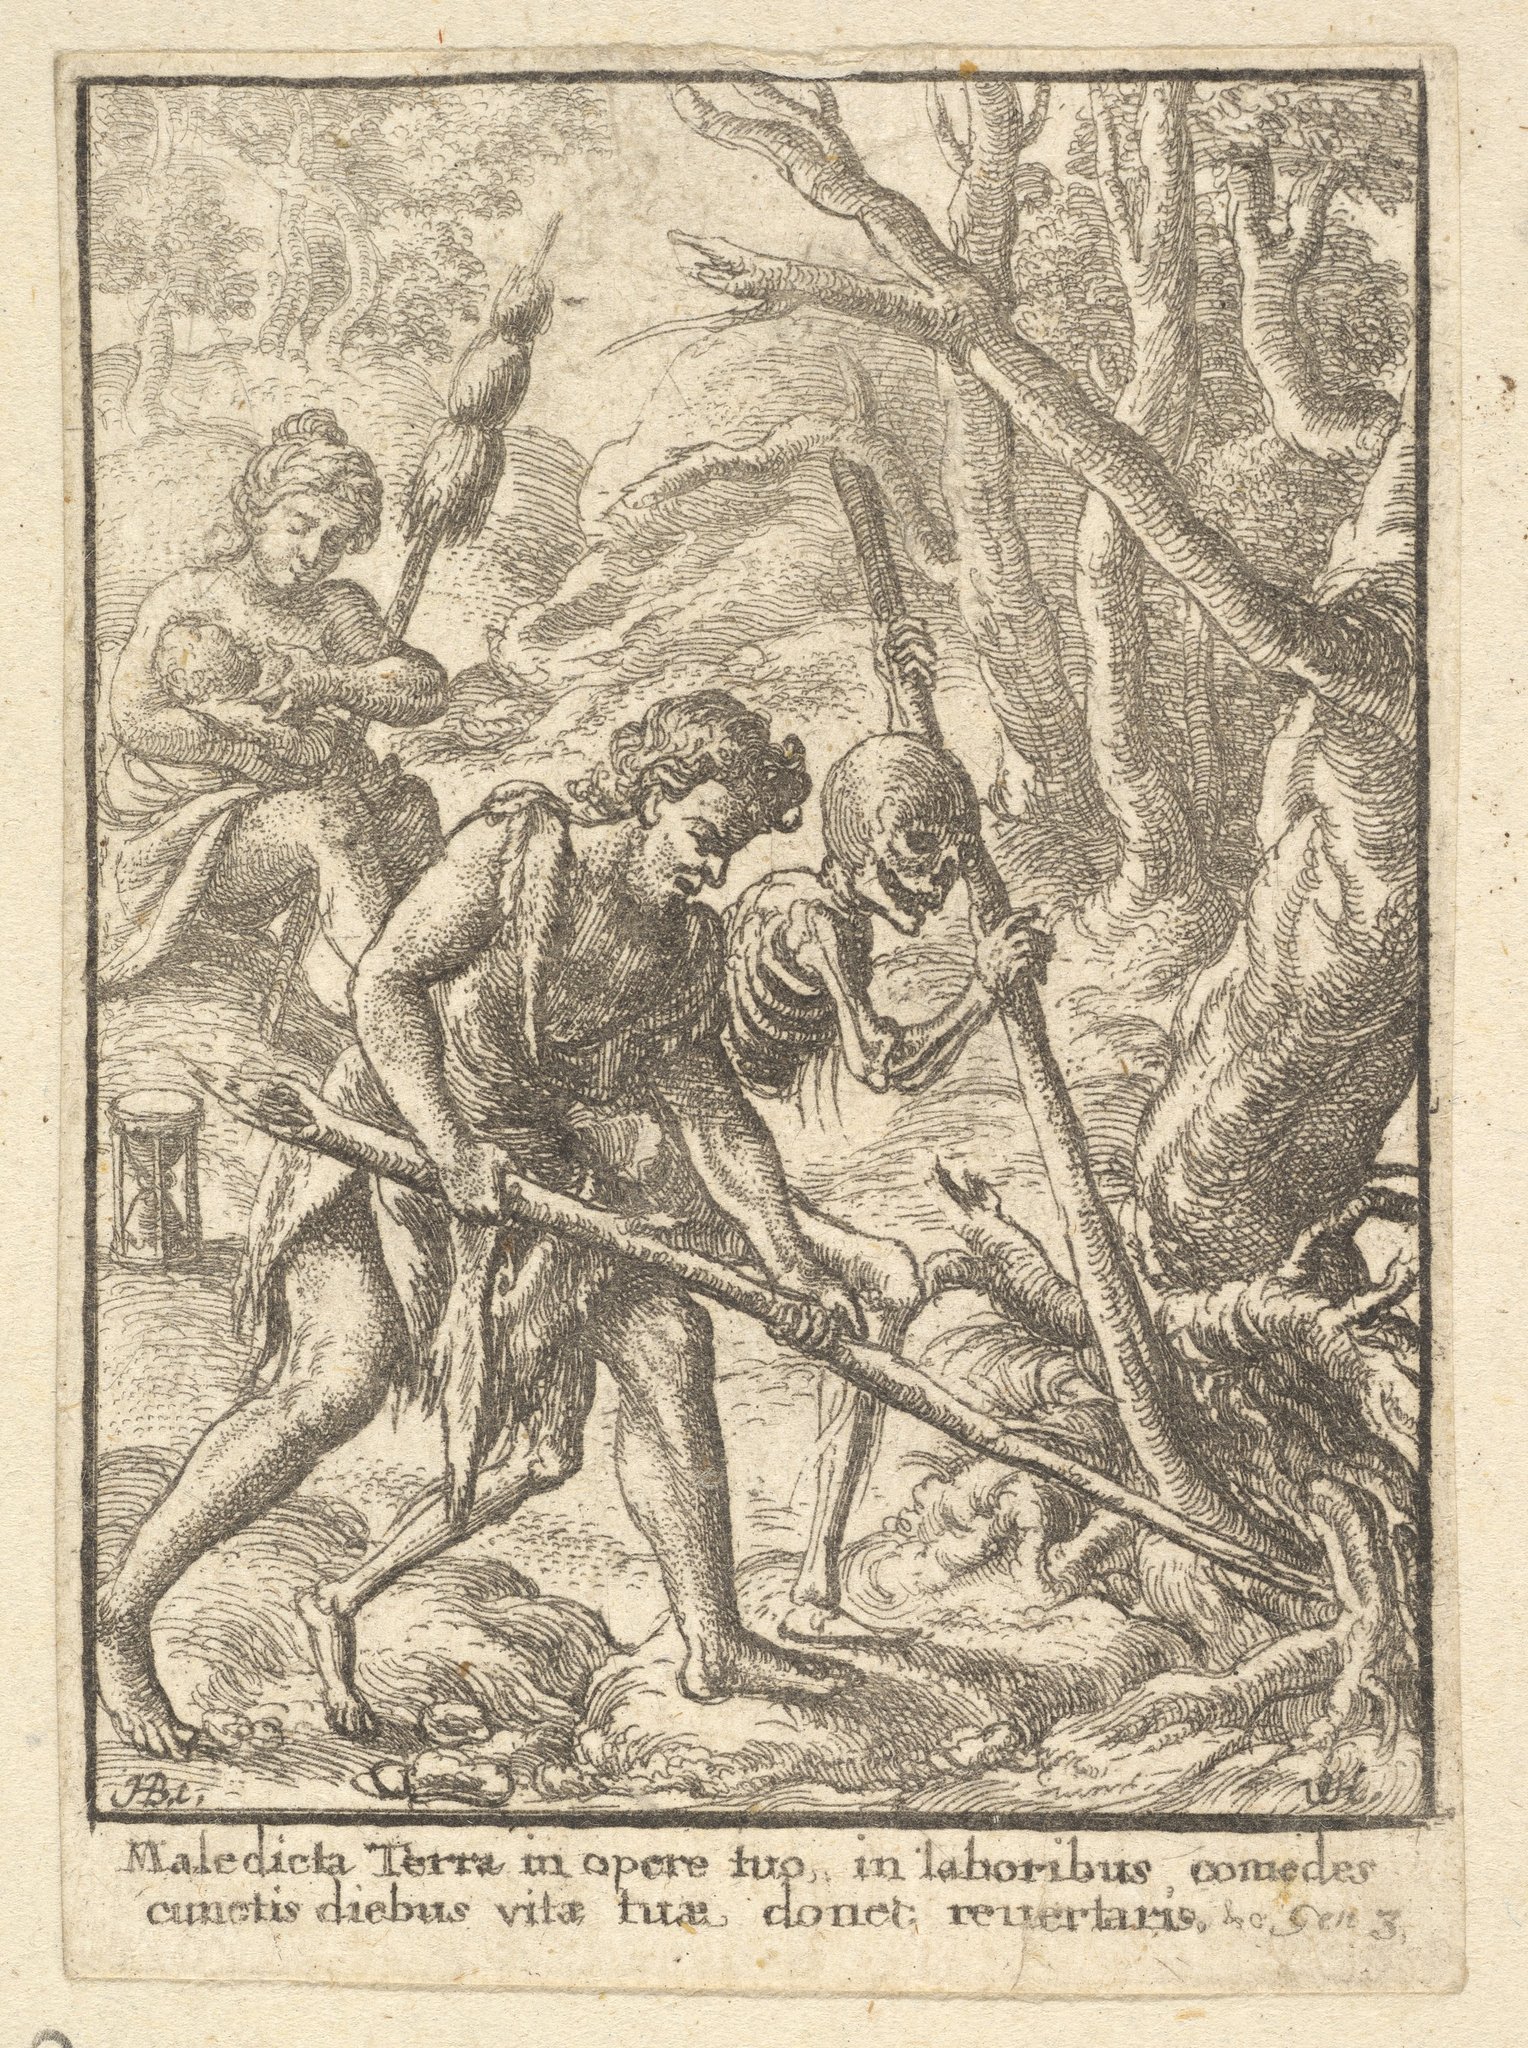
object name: print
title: Adam Ploughing from the Dance of Death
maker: wenceslaus hollar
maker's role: artist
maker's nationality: bohemian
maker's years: 1607-1677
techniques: etching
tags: skeletons,infants,women,adam